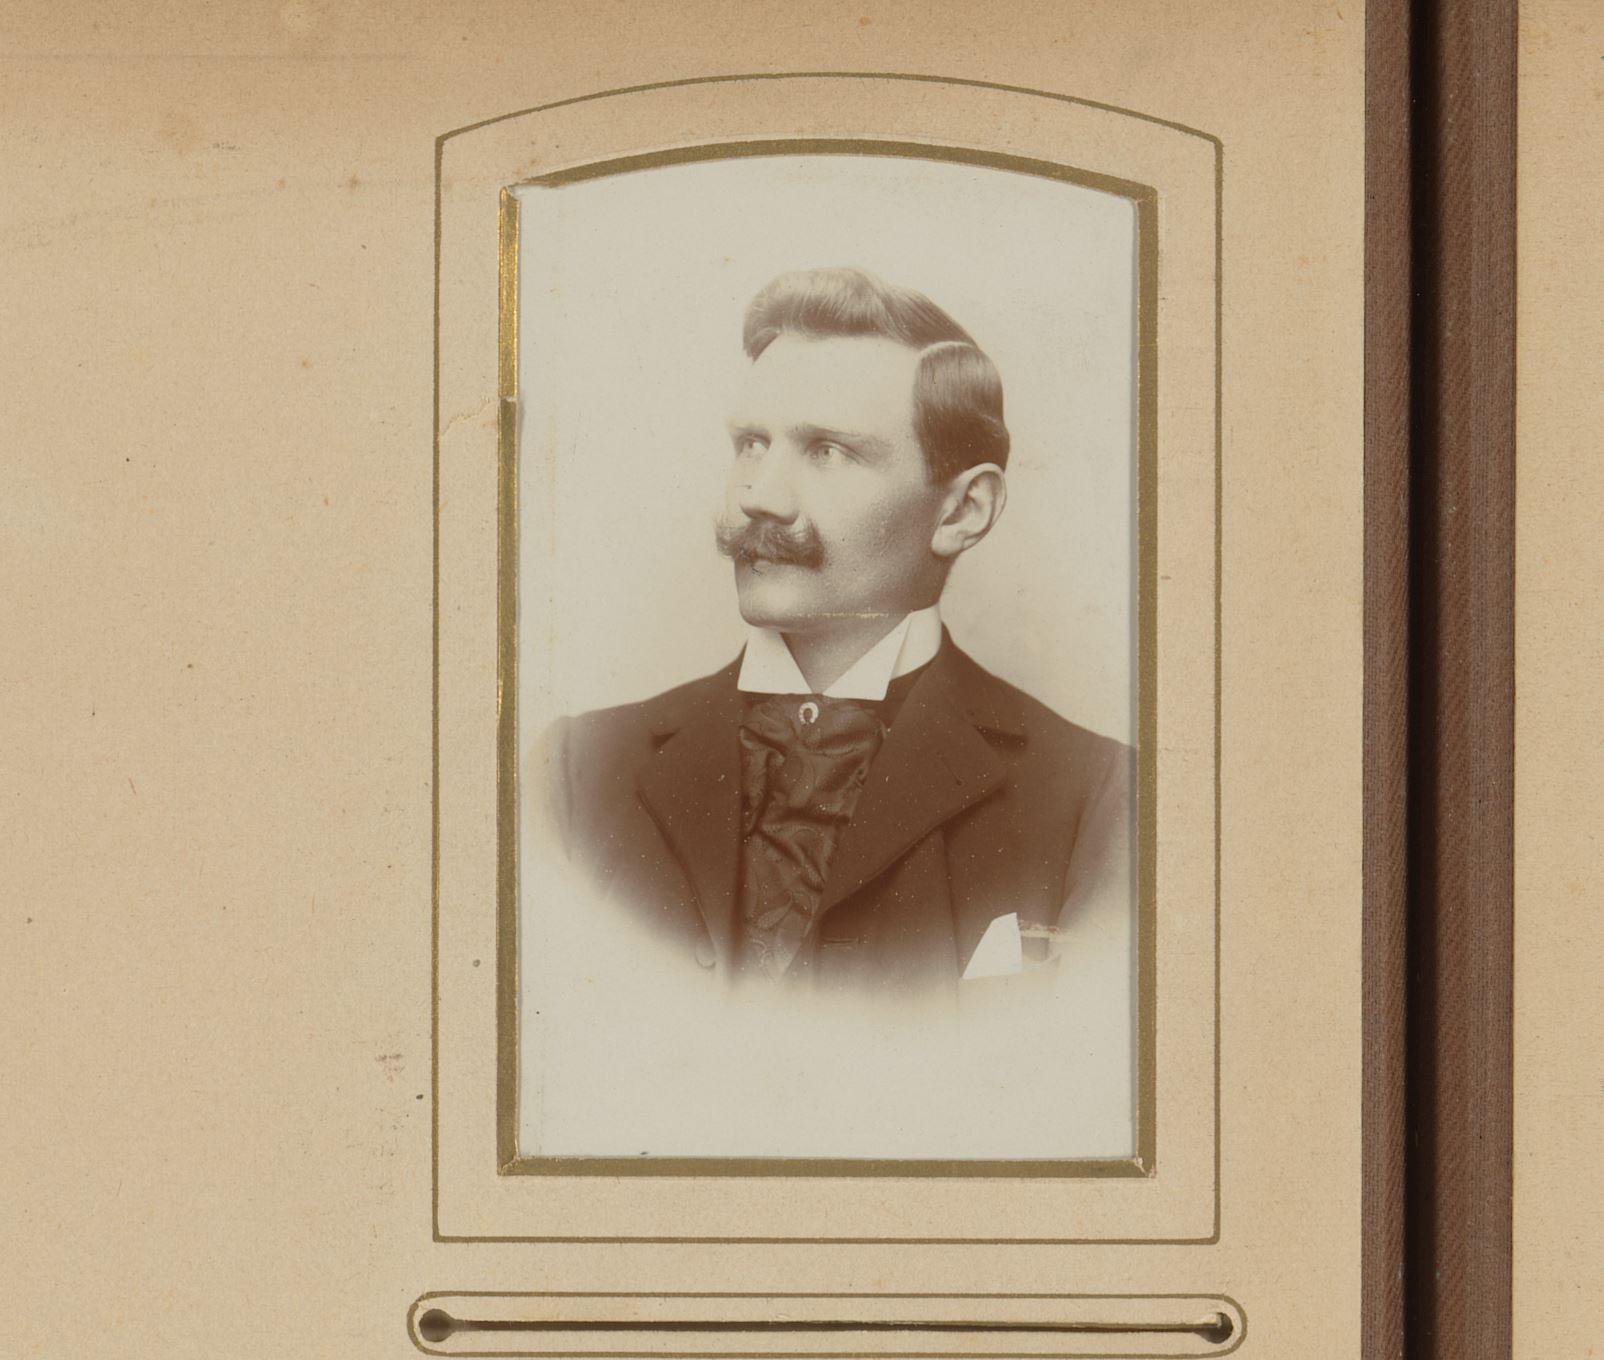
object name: photograph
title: Portret van een man met snor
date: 1894-1905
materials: cardboard, photographic support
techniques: collodion silver print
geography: hasselt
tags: moustache, historical persons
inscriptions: inscription: ‘Travaux/ pour amateurs et/ photographes/ Fournitures/ appareils/ plaques/ etc./ Spécialité d'agransissements/ Encadrements et moulures en tous genres./ Cliché No./ est conservé./ Blanckart Frères/ HASSELT./ Maison fondée en 1862.’